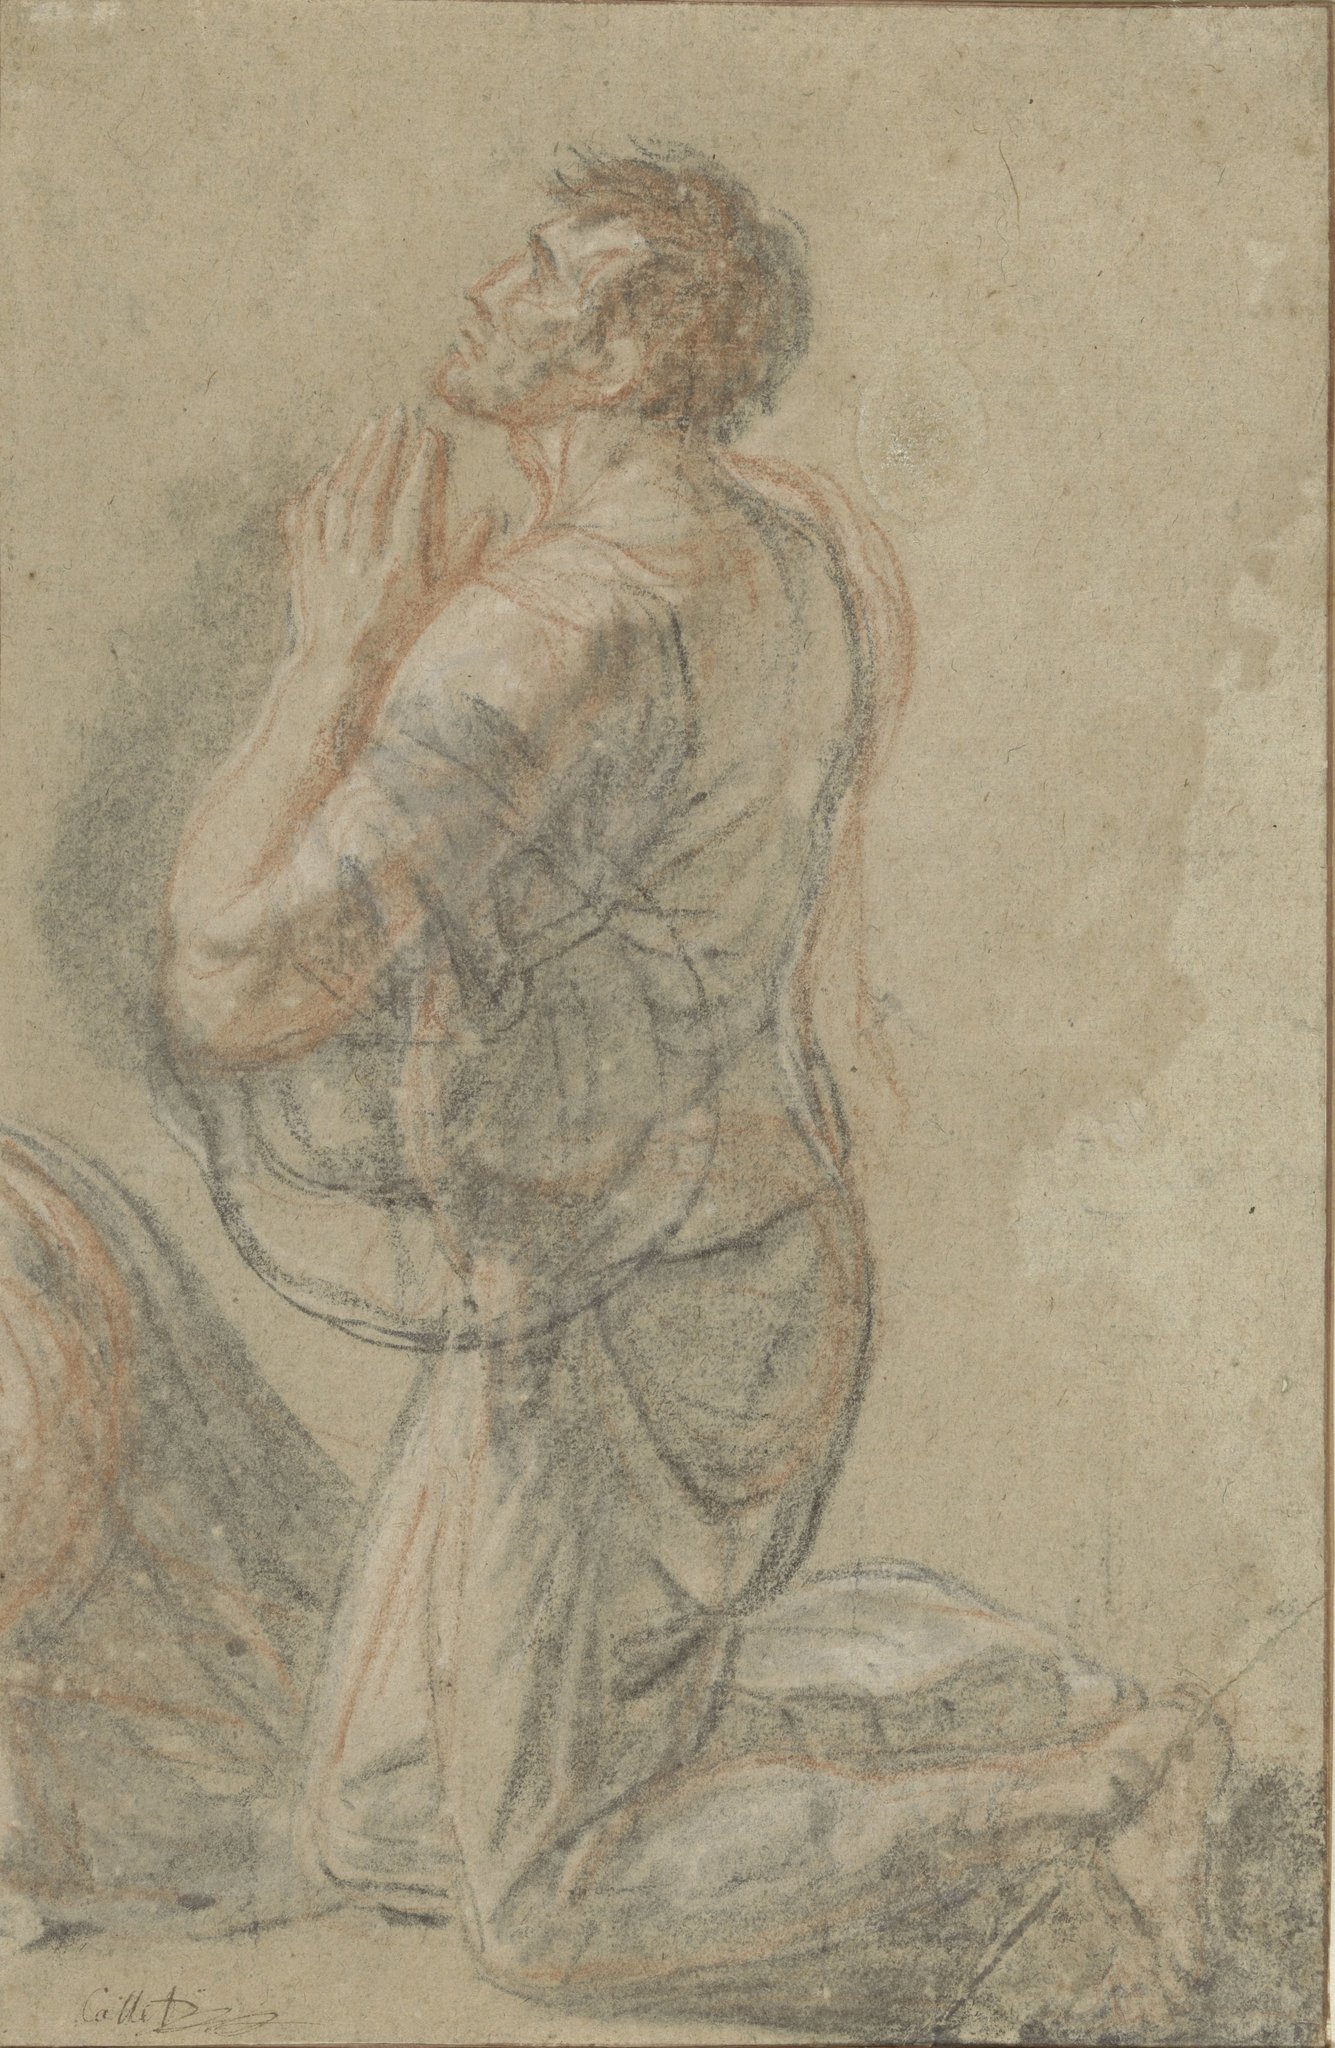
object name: drawing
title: Knielende man, van opzij gezien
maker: antoine françois callet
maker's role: draughtsman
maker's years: 1741-1823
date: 1751-1823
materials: chalk, paper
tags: kneeling figure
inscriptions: signature, recto, lower left, pen and brown ink: ‘Callet’, collector's mark: Lugt 1042, annotation: ‘Rafael del Colle / 1490-1570 / N-[?] 390 / H/127 / 57 […] / 304 [?]’